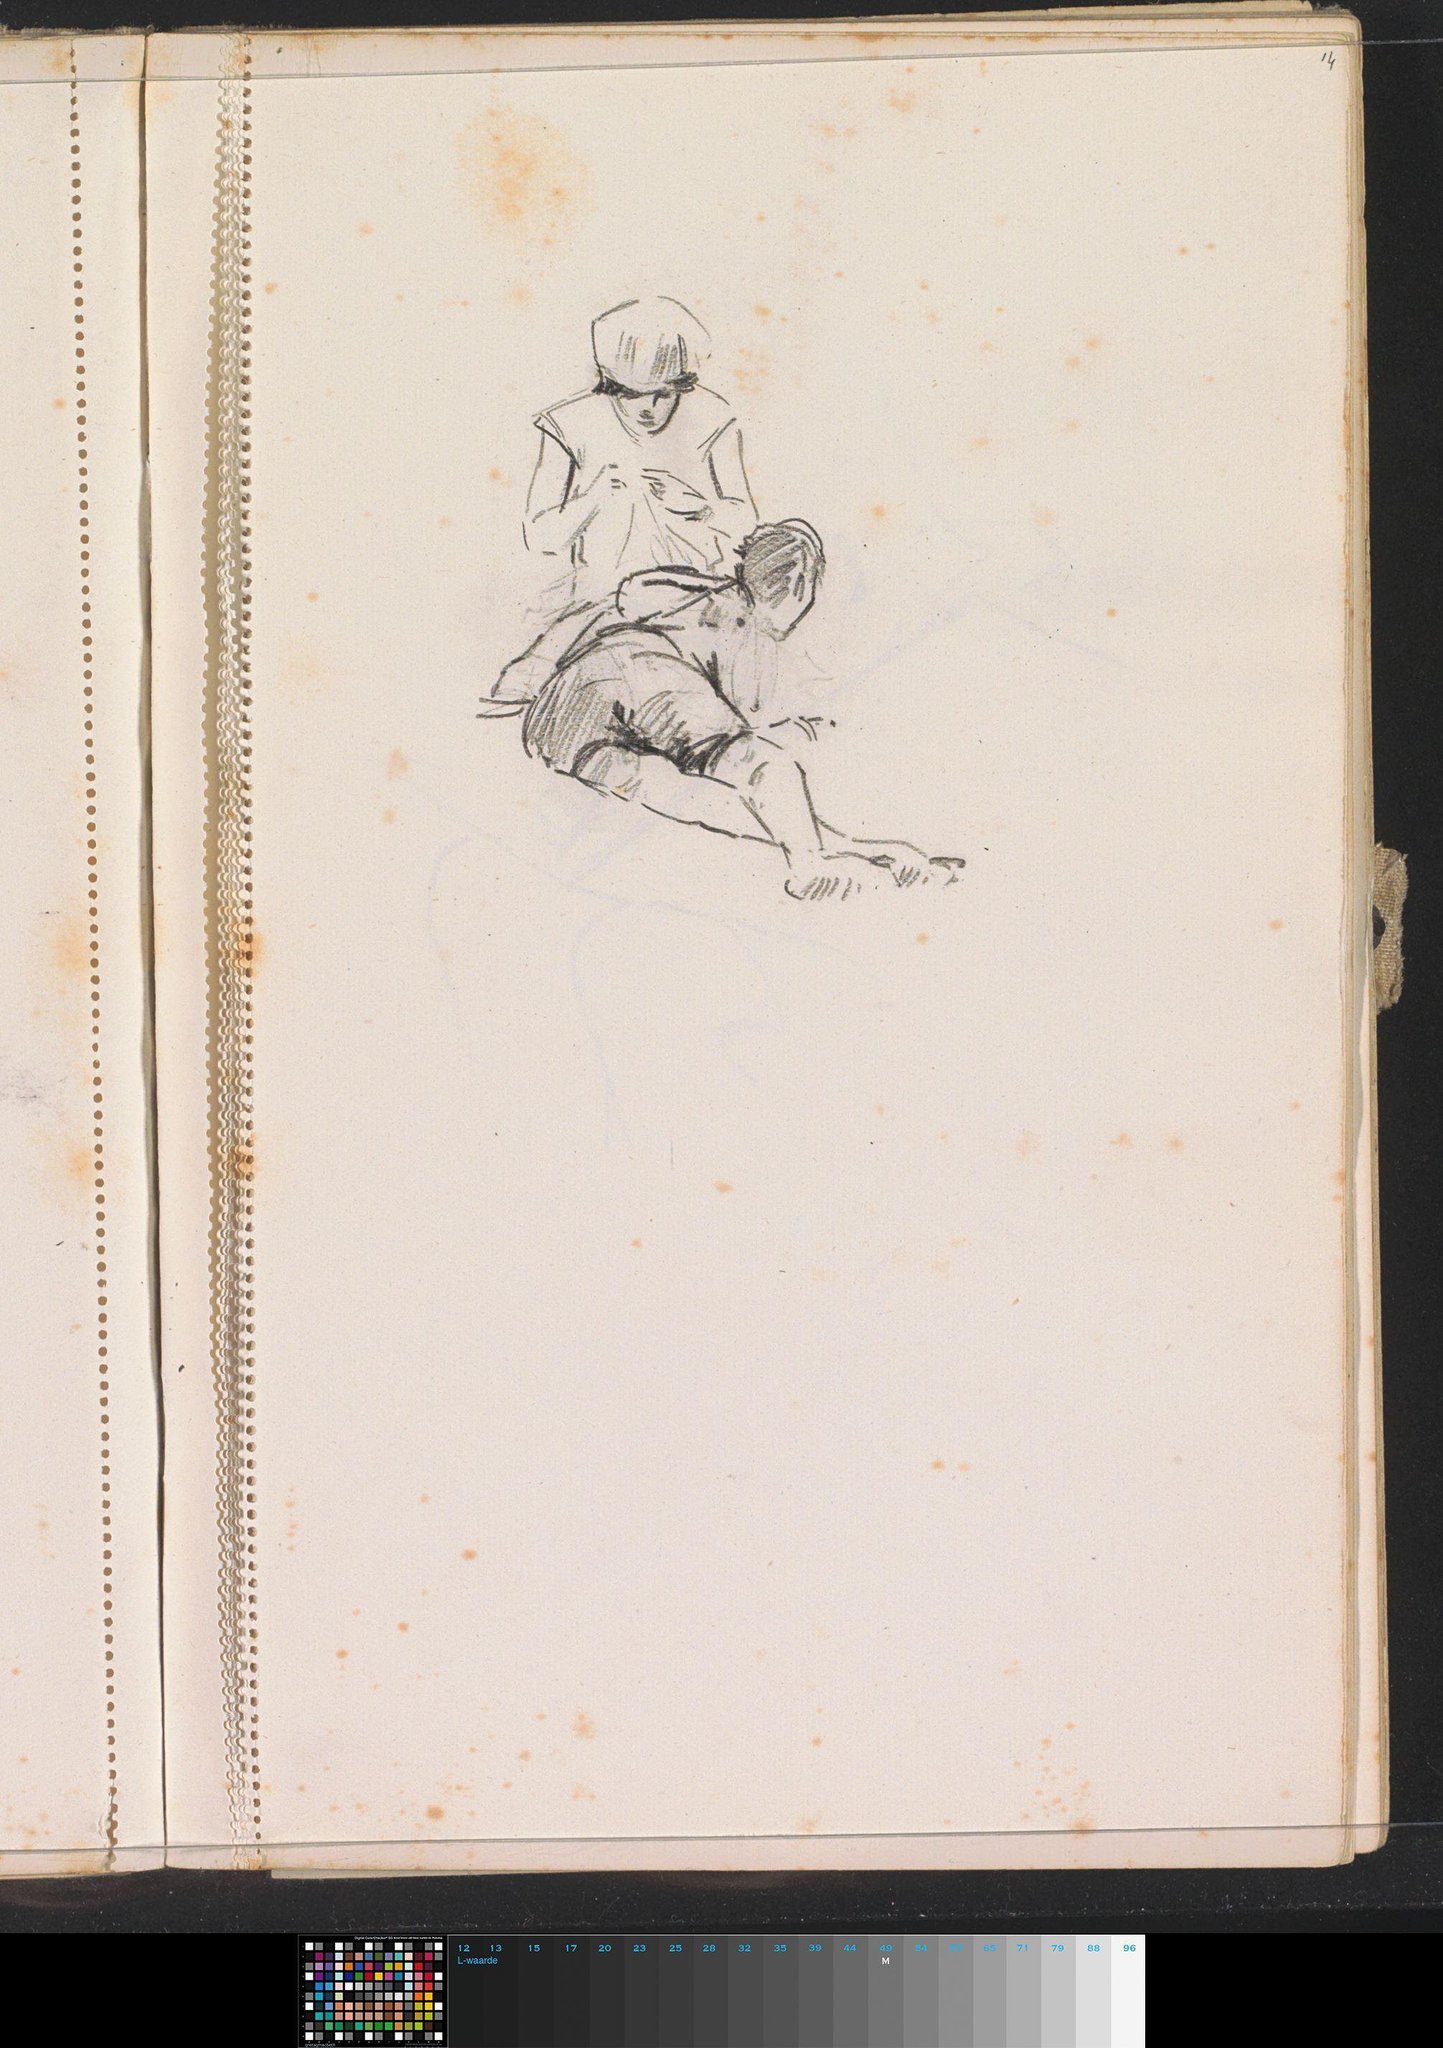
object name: sketchbook leaf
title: Liggende jongen naast een handwerkend meisje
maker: otto verhagen (i)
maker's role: draughtsman, print maker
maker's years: 1885-1951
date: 1928-1930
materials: chalk, paper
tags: sitting figure - aa - female human figure, lying figure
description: Pagina 14 uit een schetsboek met 51 bladen.